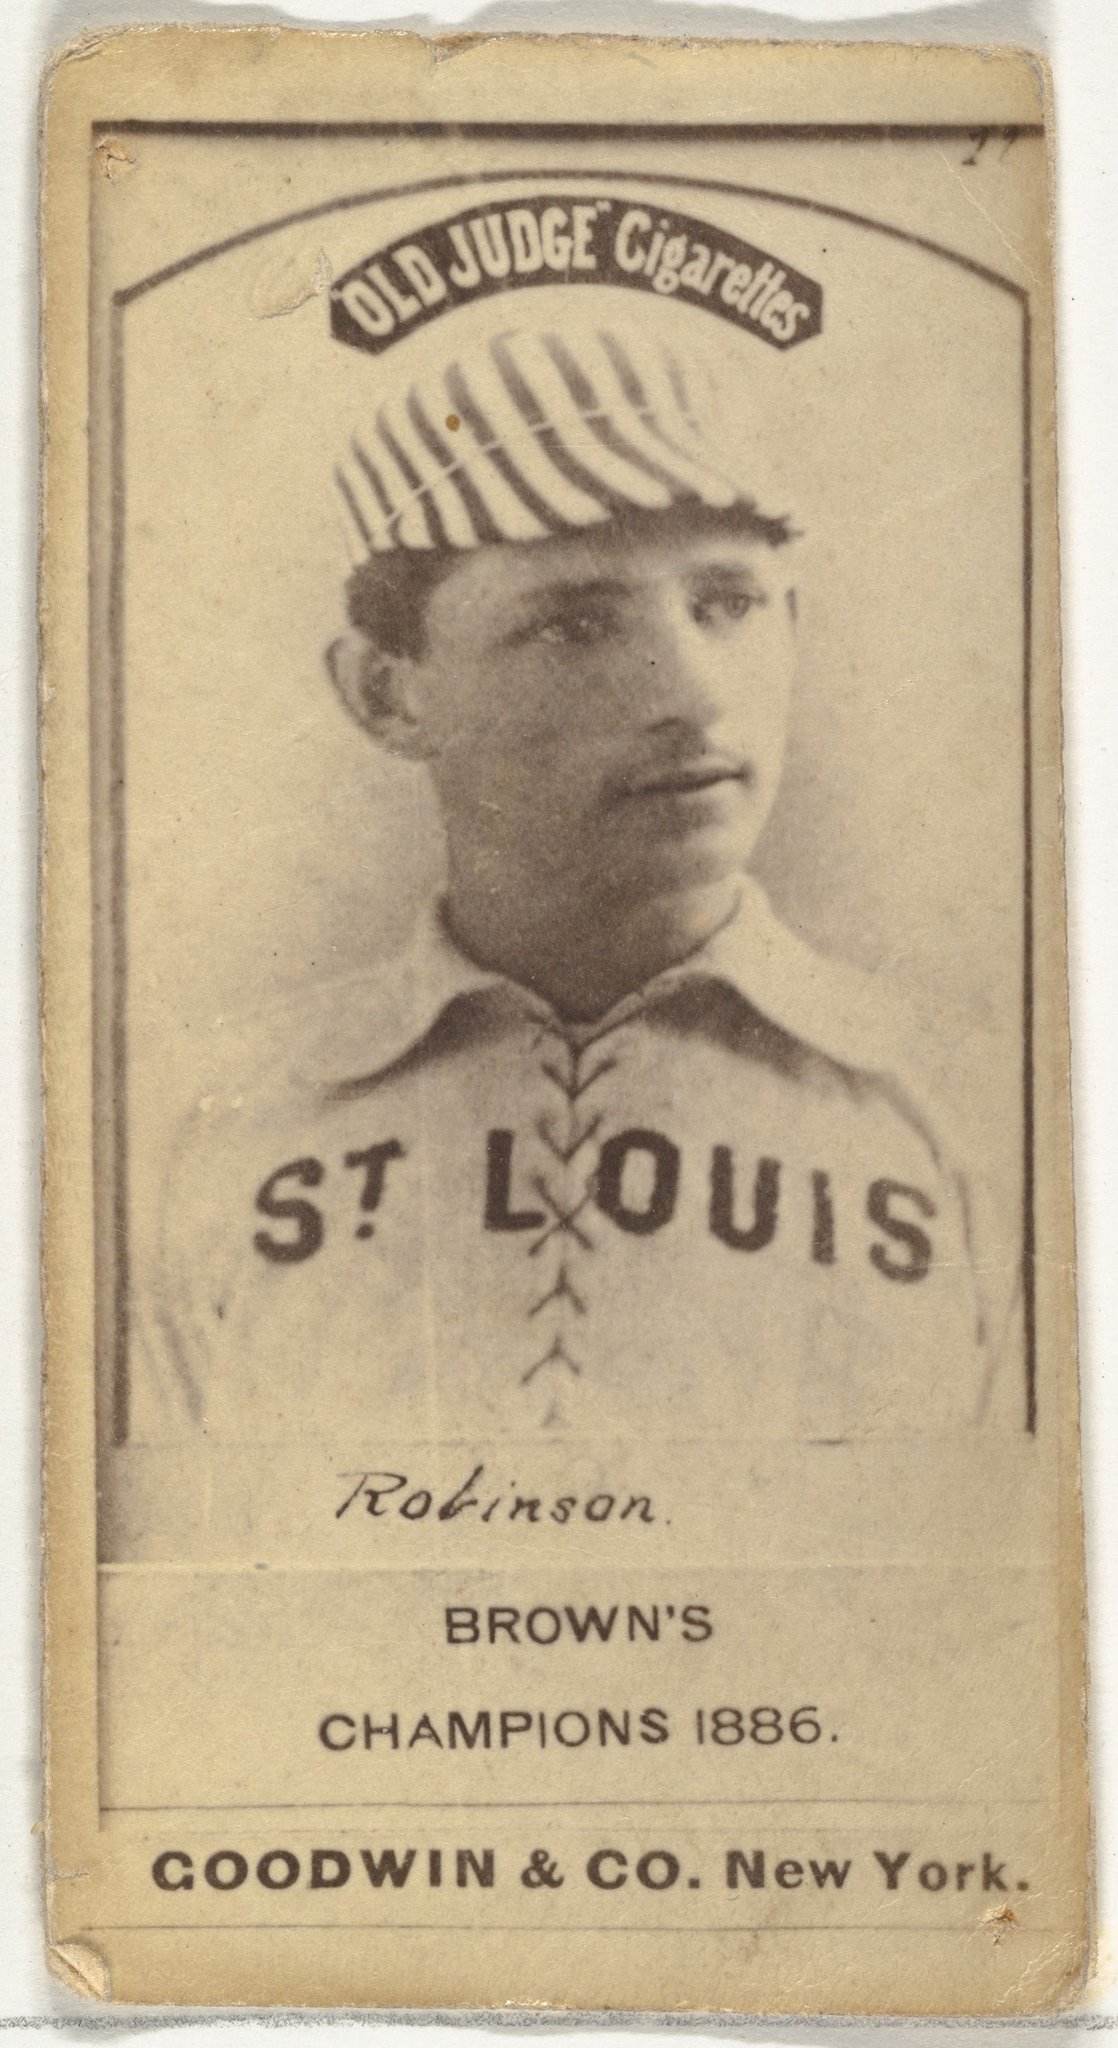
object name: baseball card, photograph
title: William H. "Yank" Robinson, Shortstop, St. Louis Browns, from the Old Judge series (N172) for Old Judge Cigarettes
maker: goodwin & company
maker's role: publisher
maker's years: 1850-1950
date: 1886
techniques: albumen silver print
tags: men,portraits,baseball,athletes